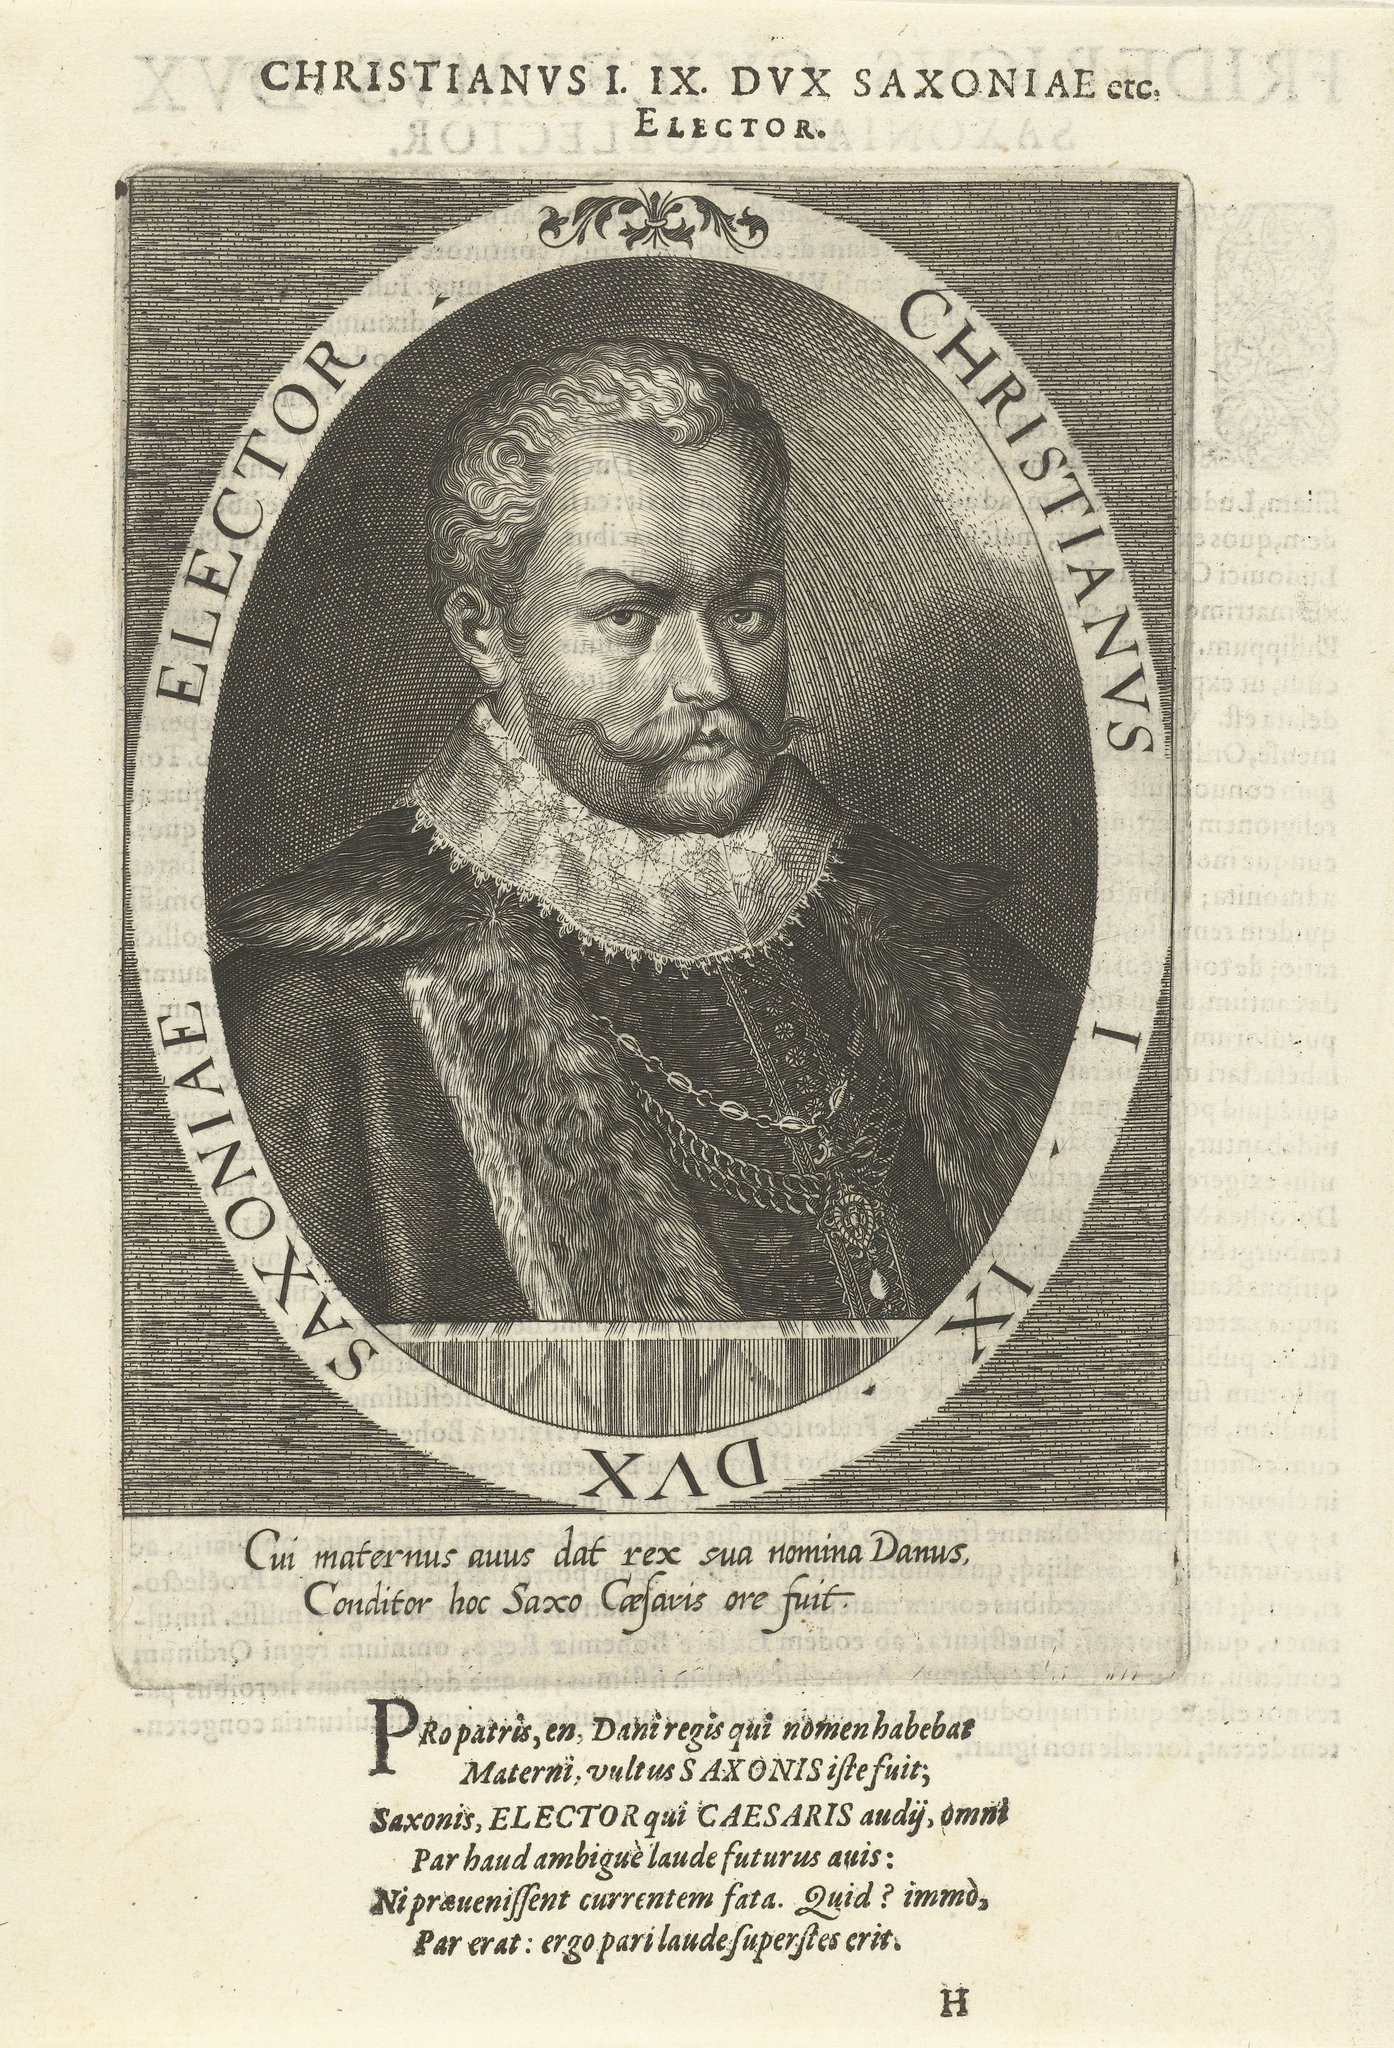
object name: print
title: Portret van Christiaan I van Saksen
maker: dominicus custos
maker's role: print maker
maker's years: 1560-1615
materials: paper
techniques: engraving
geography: augsburg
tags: christiaan i van saksen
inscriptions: collector's mark: Lugt 2228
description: Illustratie uit: Saxoniae Ducum. Caesarib. Creand. VIIVirum; et caeterorum A Friderico I. Ad Christianum II. Fratres Et Agnatos, Genuinae effig. Augsburg: D. Custos en M. Manger, 1601, of latere editie.